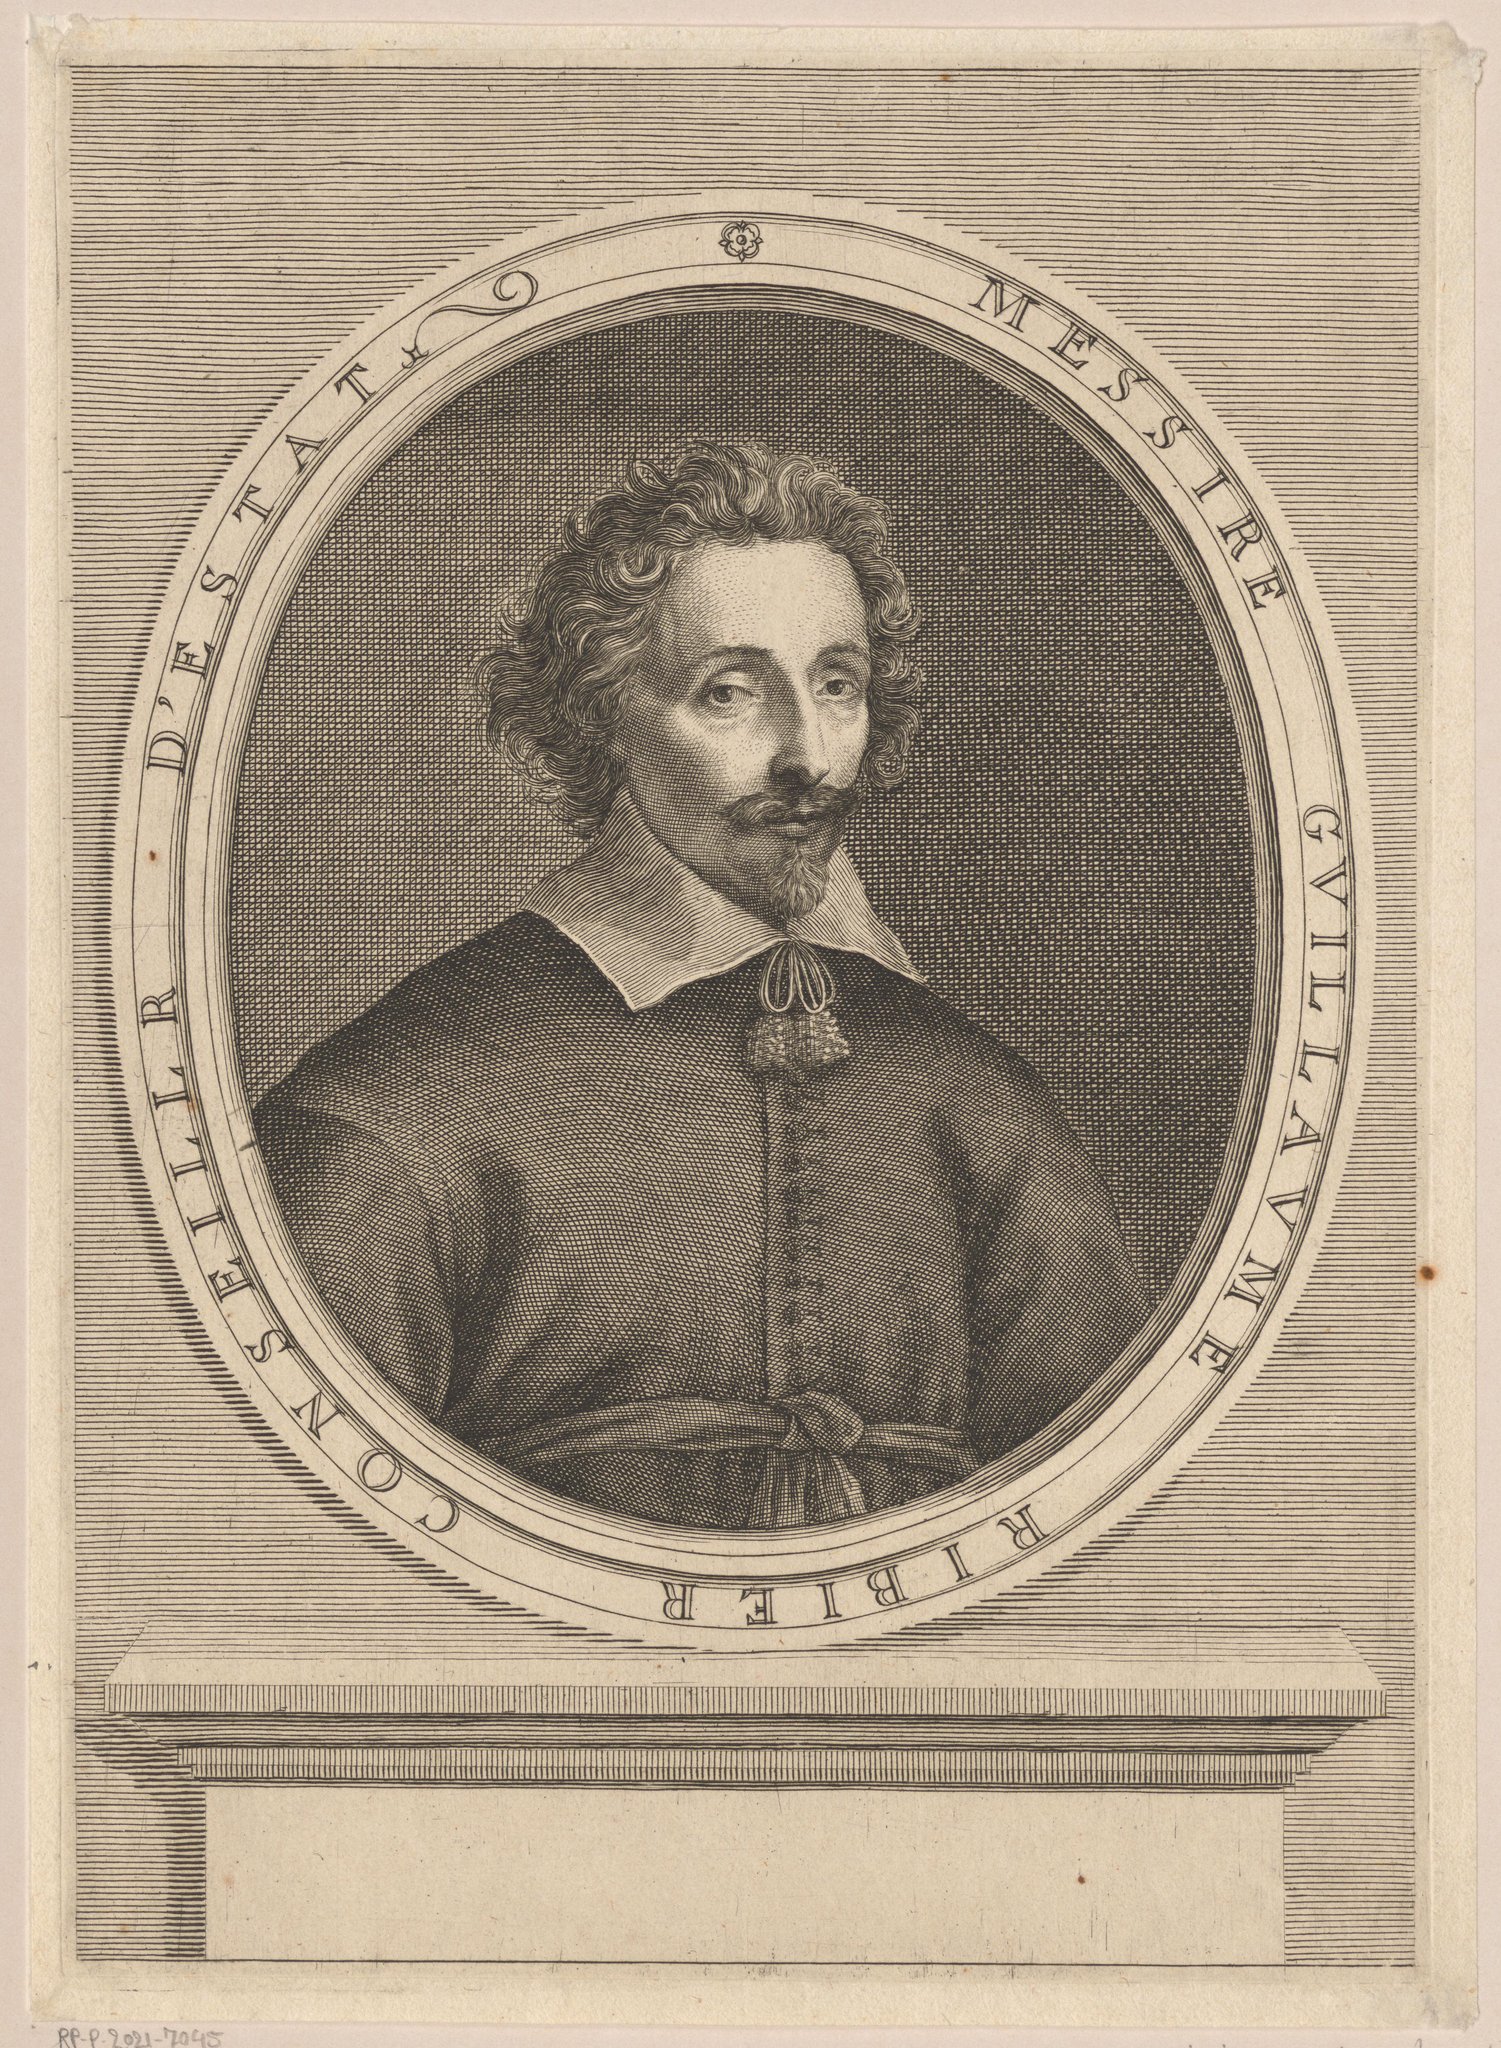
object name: print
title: Portret van Guillaume Ribier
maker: Anonymous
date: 1598-1699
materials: paper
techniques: engraving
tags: historical persons